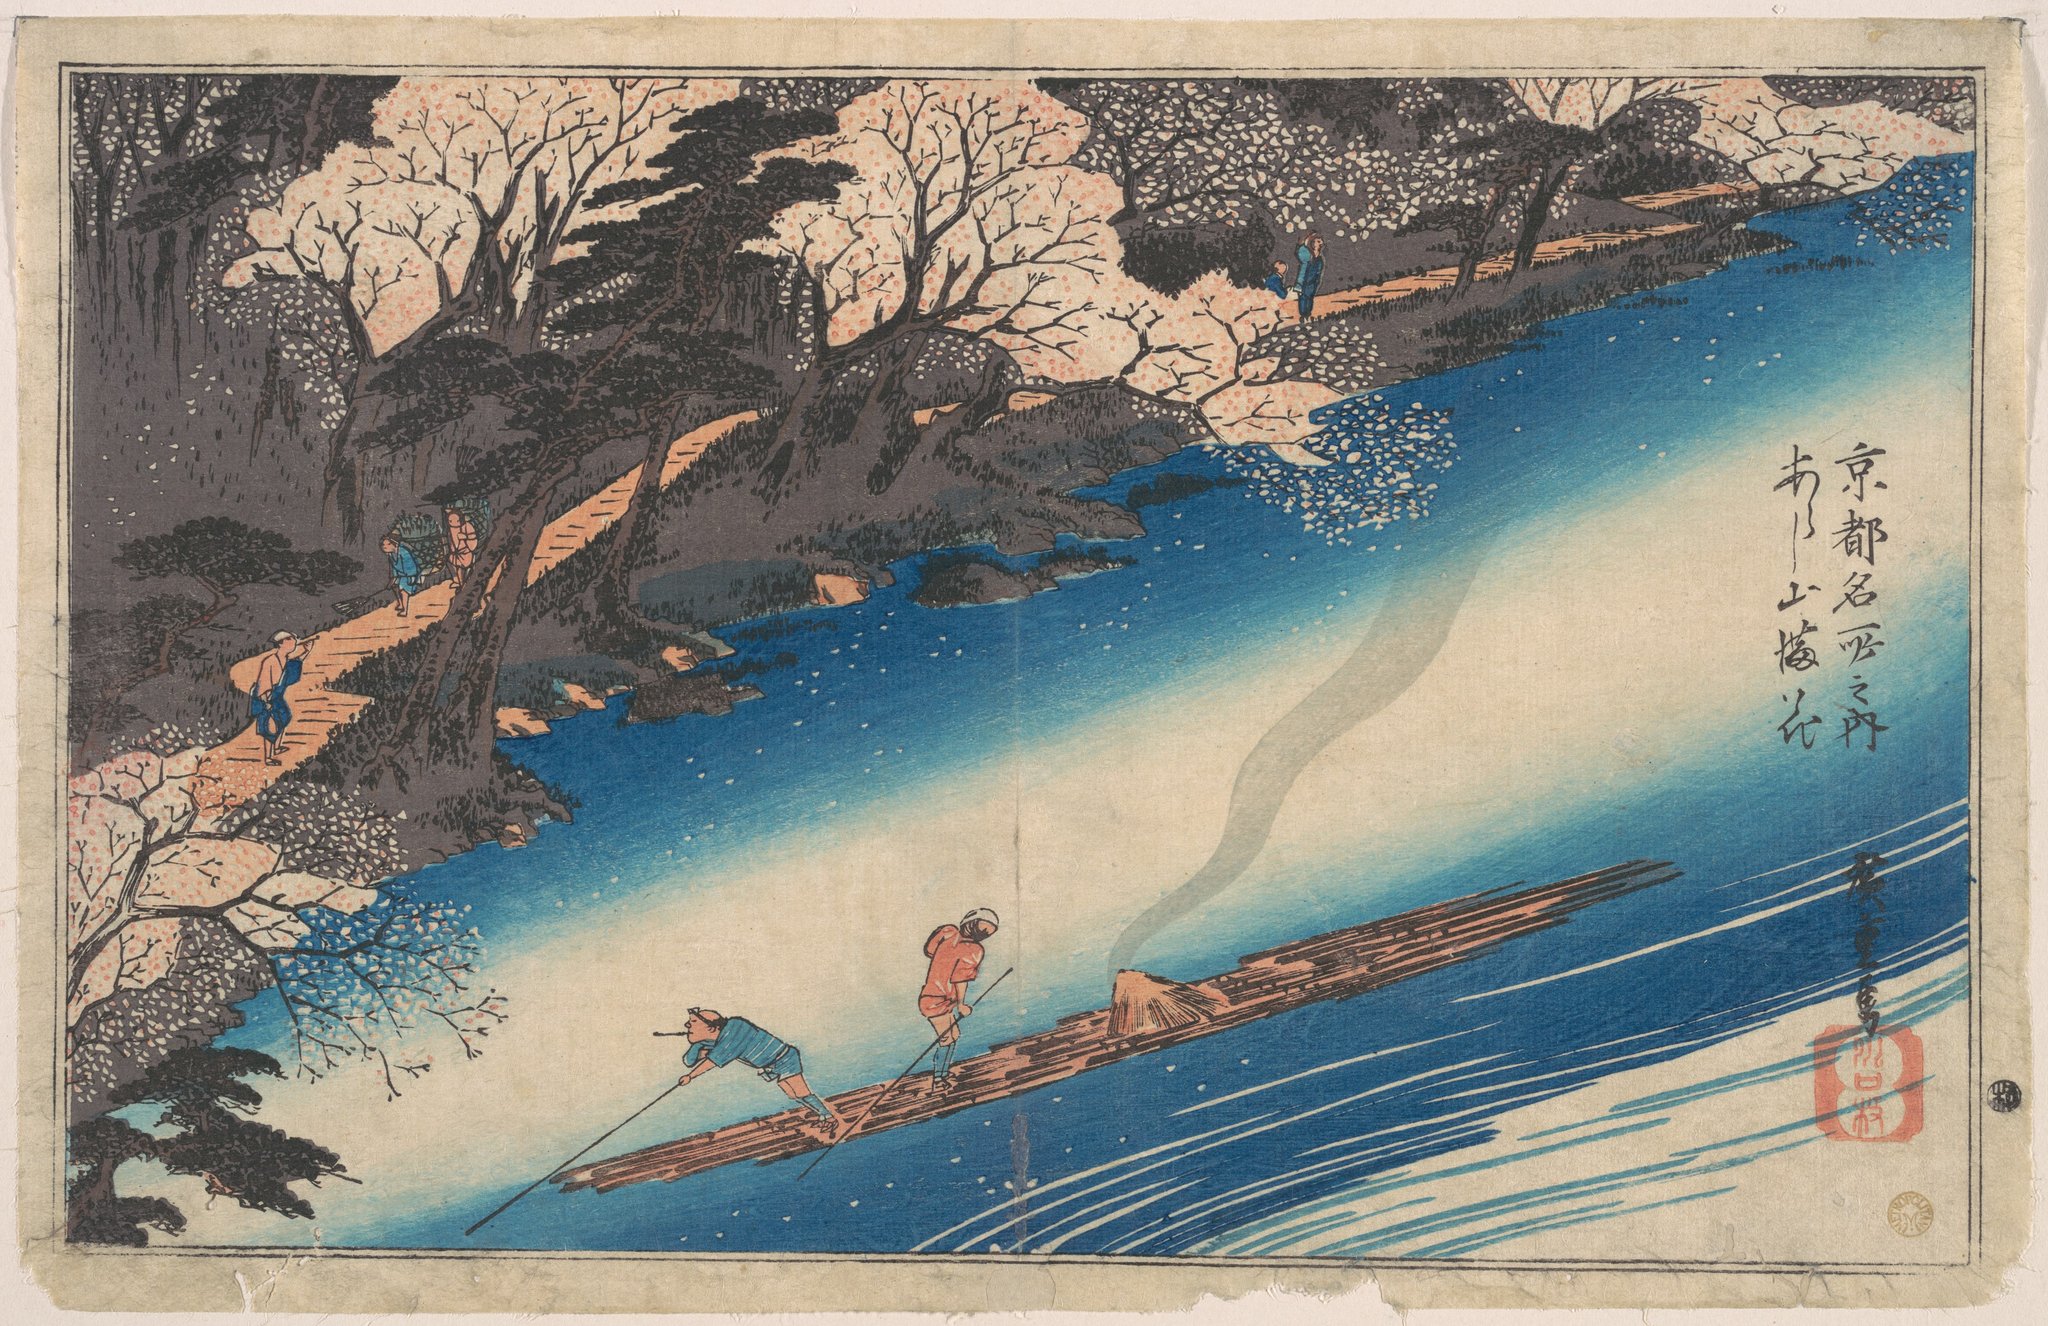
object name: print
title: Cherry Blossoms at Arashiyama, from the series Famous Places of Kyōto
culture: japanese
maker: utagawa hiroshige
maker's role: artist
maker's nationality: japanese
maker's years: 1797-1858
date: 1834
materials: ink, paper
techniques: woodblock print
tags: human figures,trees,boats